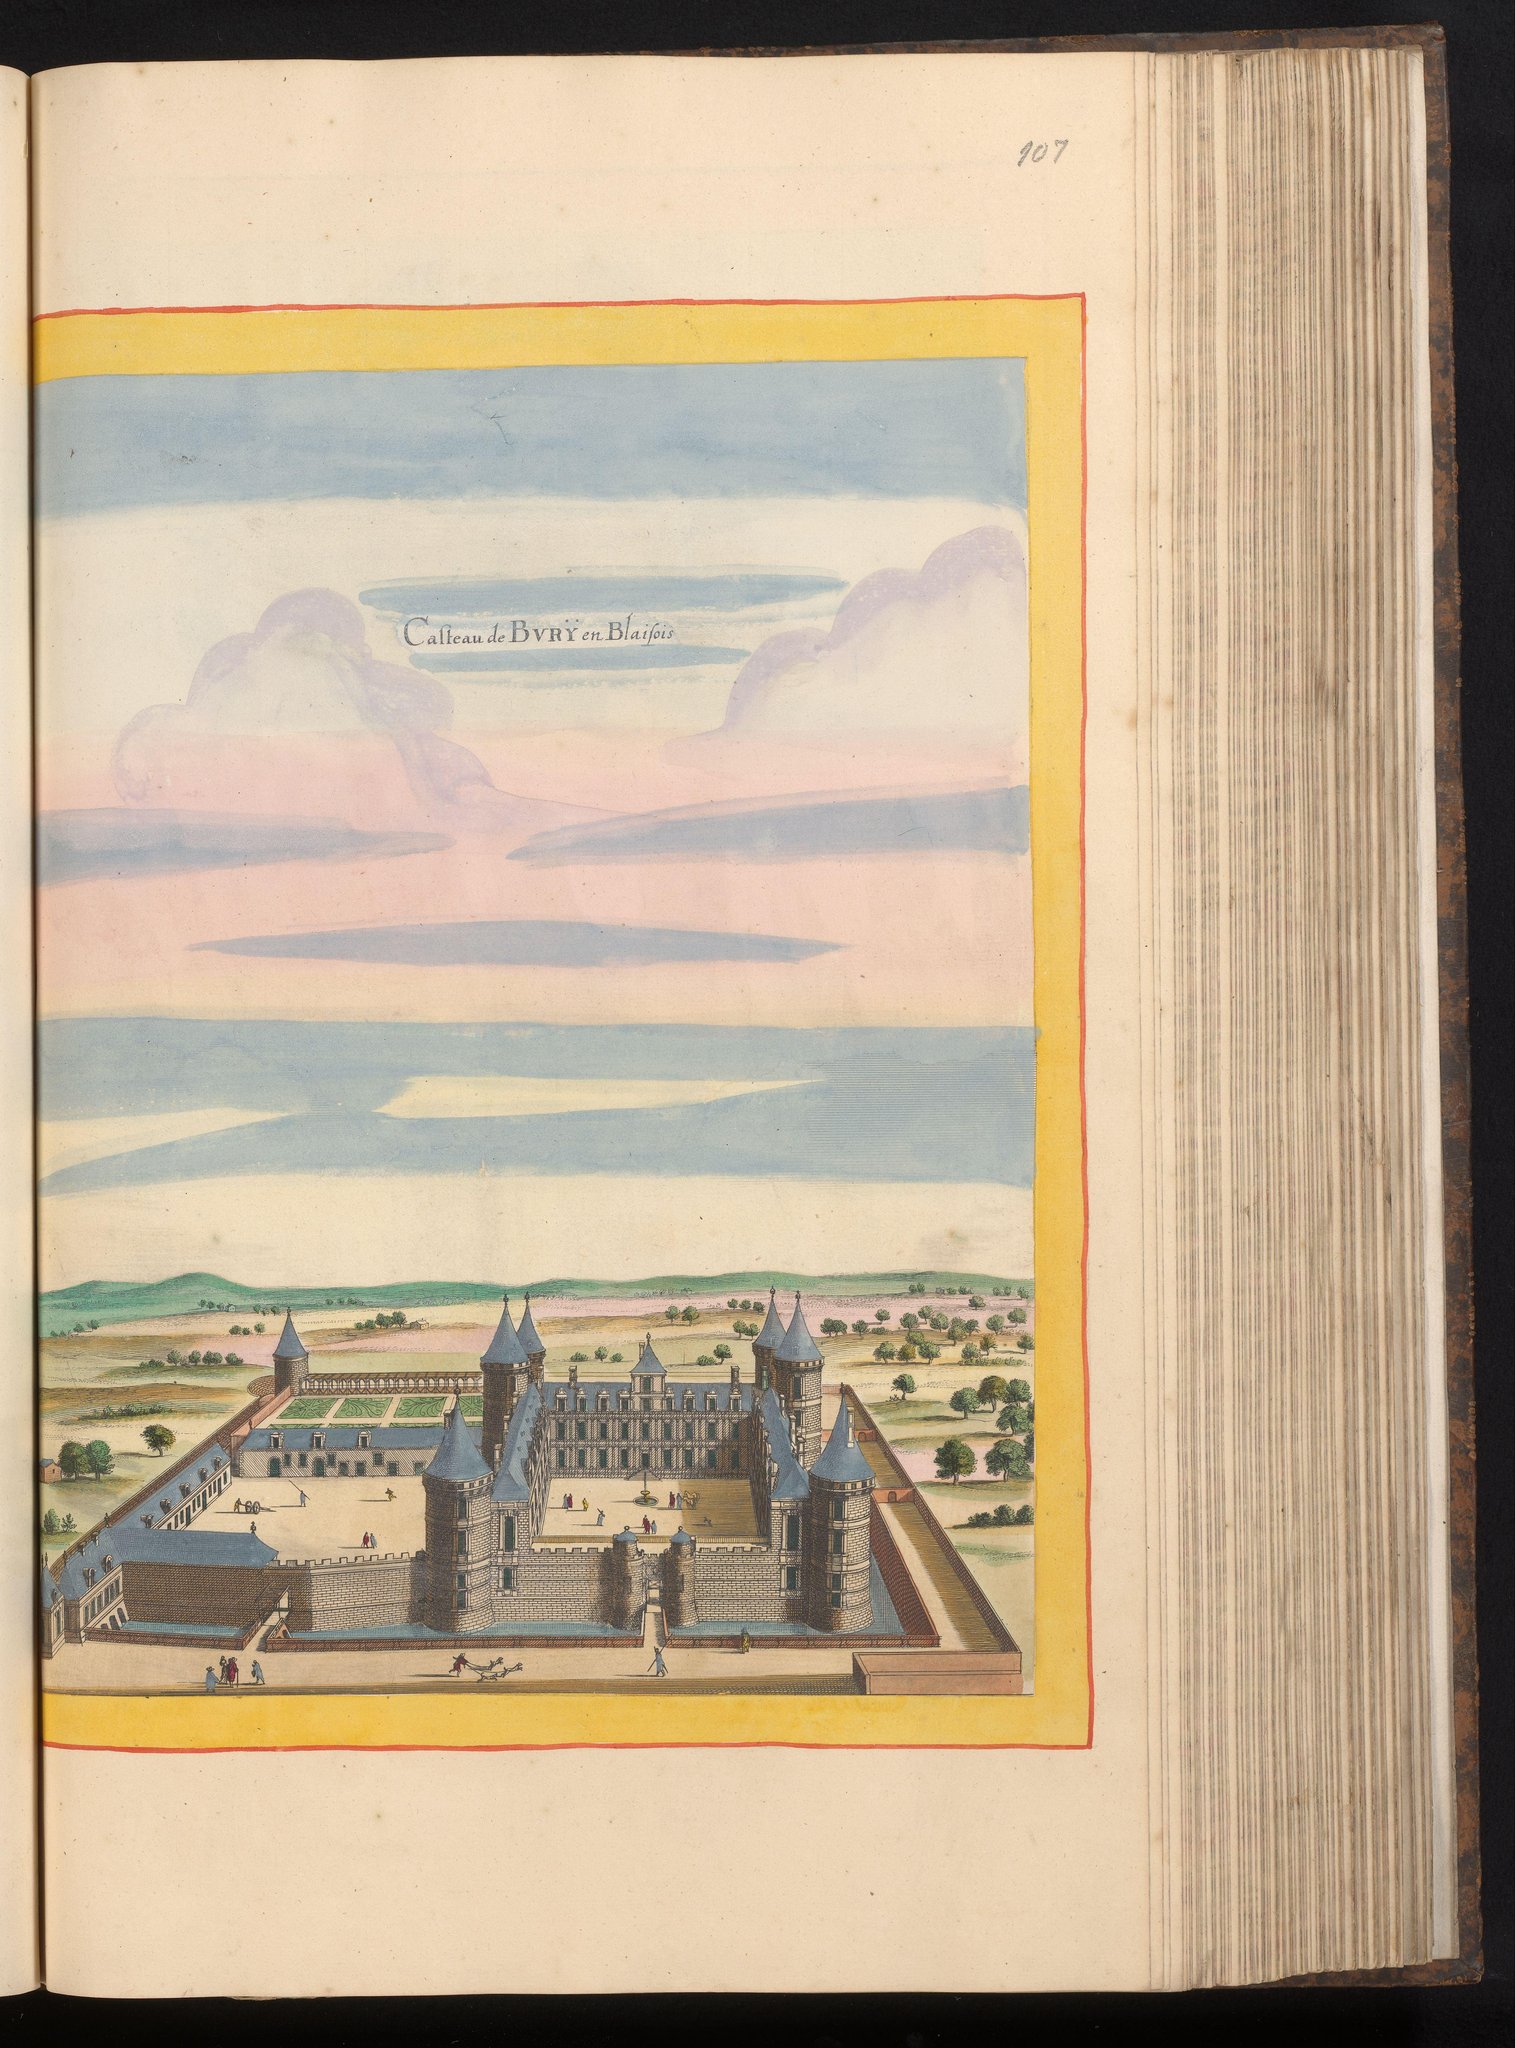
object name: print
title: Chasteau de Bury en Blaisois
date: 1657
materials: paper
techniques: engraving, etching, hand coloring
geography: the hague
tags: castle, landscape with tower or castle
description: Prent uit: Zeiller, Martin. Topographia Galliae. 13 dln. Frankfurt: Caspar Merian, 1657, dl. 7, na p. 62. De titel is uit de originele prent gesneden. Boven de gravure is een deel lucht en wolken (bij)geschilderd, waarin de titel gelijmd is.